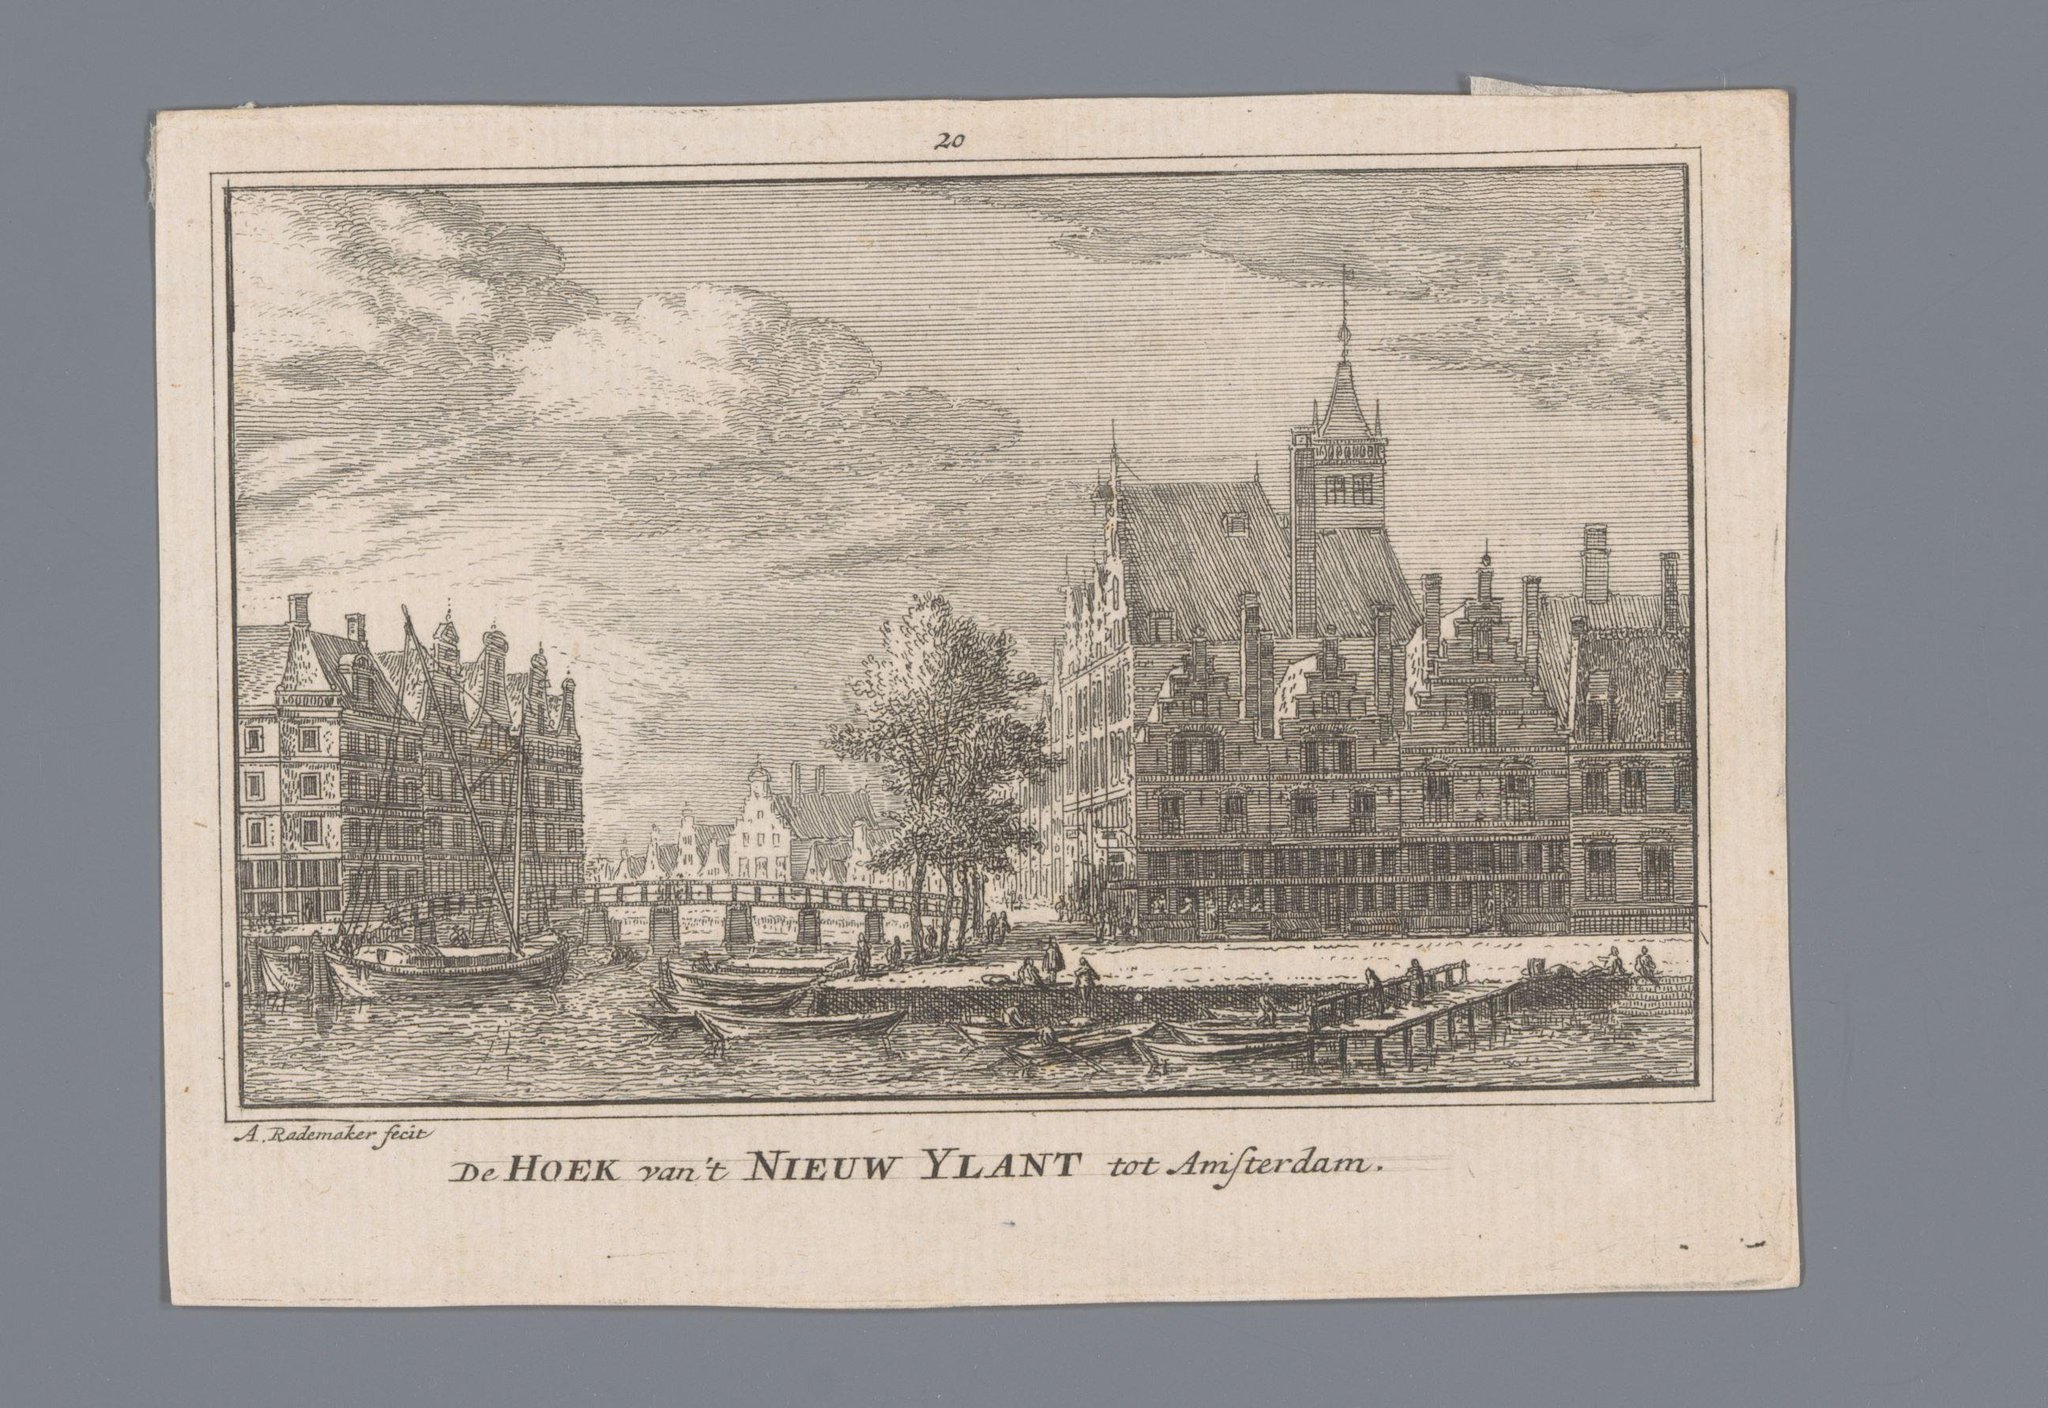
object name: print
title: Gezicht op het Waalseiland te Amsterdam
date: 1725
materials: paper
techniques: etching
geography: amsterdam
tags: bridge in city across river, canal, etc. (+ city(-scape) with figures, staffage), canals, waters (in city) (+ city(-scape) with figures, staffage)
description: Prent voor het eerst gebruikt in: Rademaker, Abraham. Kabinet van Nederlandsche outheden en gezichten: vervat in 300 konstplaaten (…). 2 dln. Amsterdam: Willem Barents, 1725, dl. 1, ill. 20. Daarna is de prent in verschillende heruitgaven verschenen, uitgegeven in 1727-1733, 1770-1771 en 1792-1803.